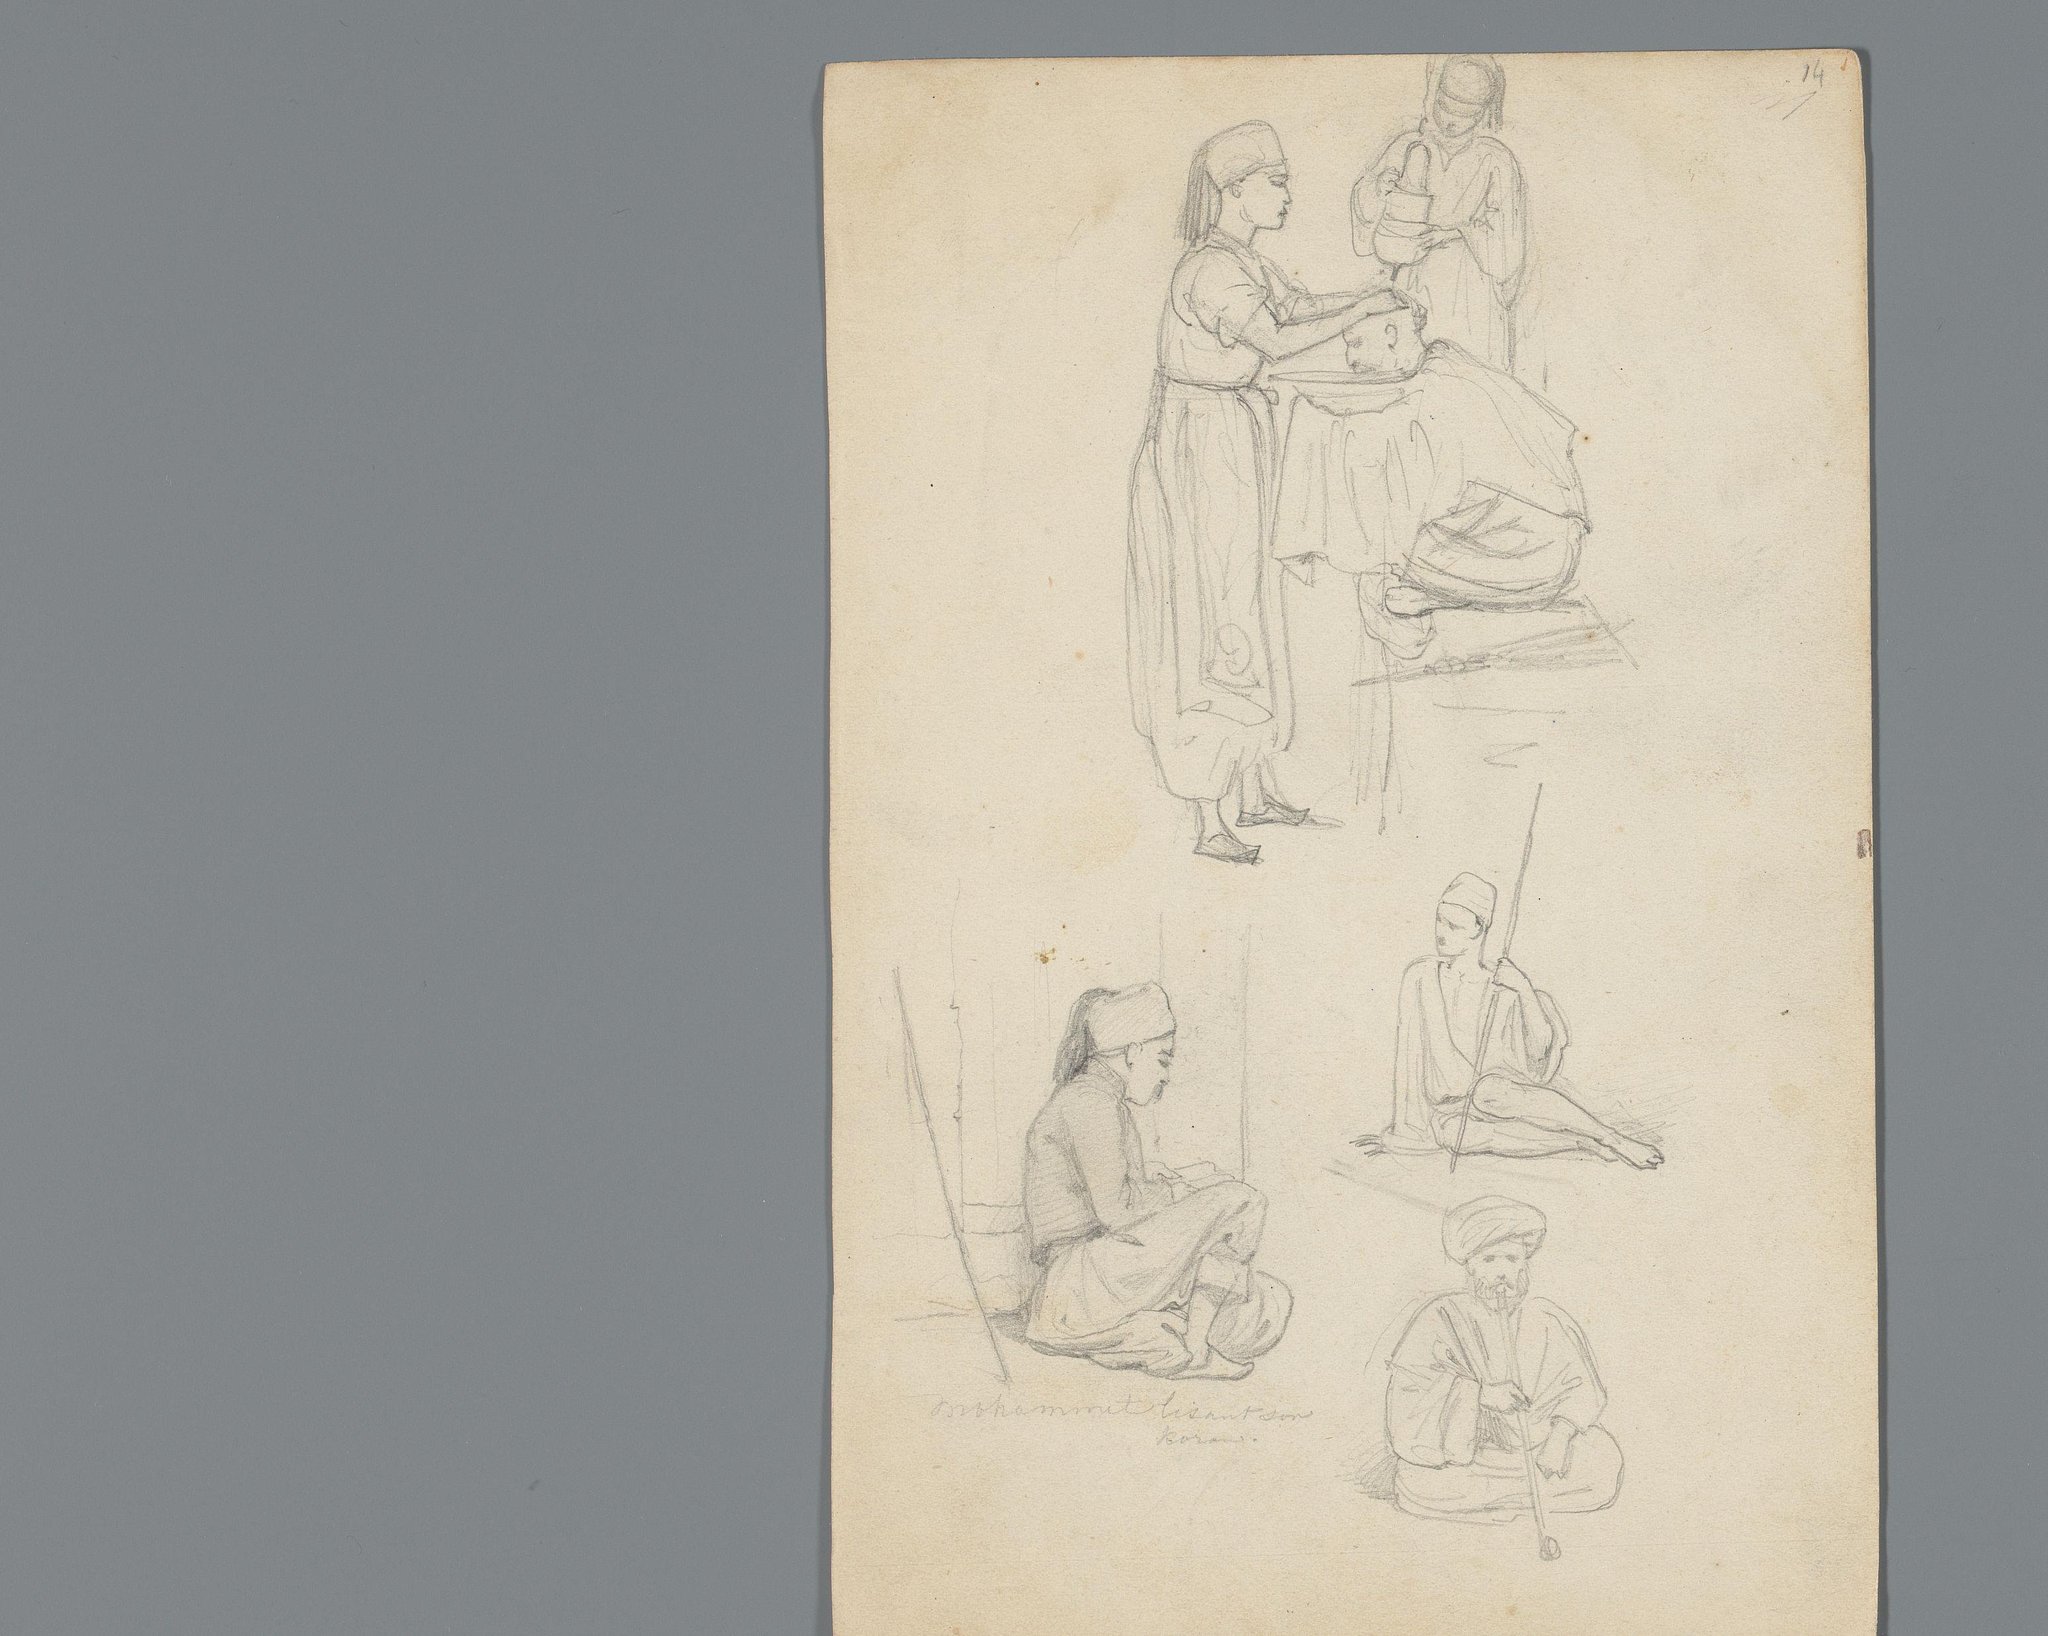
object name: drawing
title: Compositie met staande en zittende Egyptenaren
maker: willem de famars testas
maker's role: draughtsman, painter, print maker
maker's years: 1834-1896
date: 1858-1859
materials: paper, pencil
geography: egypt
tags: adult man, sitting on the ground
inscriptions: number: ‘14’, inscription: ‘Mohammet lisant son Koran’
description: Onderdeel van 20 losse bladen met tekeningen gemaakt tijdens Famars Testas zijn Egyptische reis van 1858, met voornamelijk figuren en dorpsgezichten met notities.